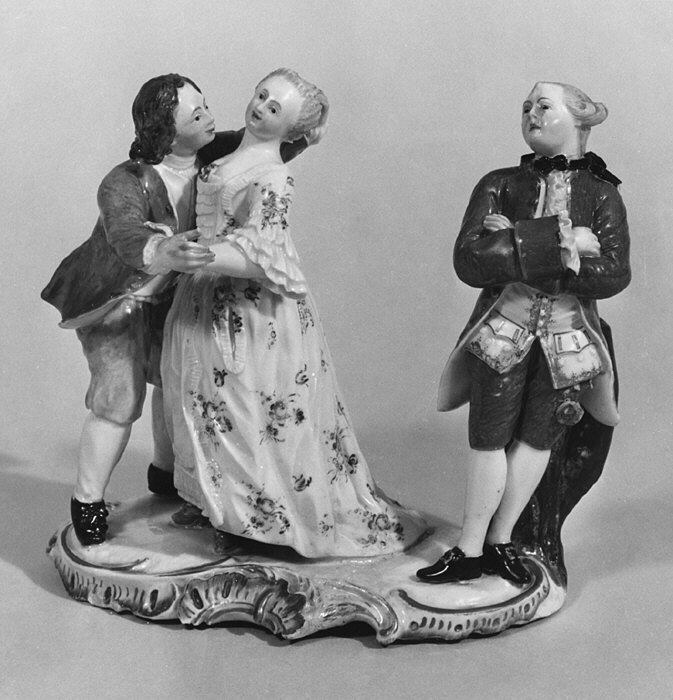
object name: group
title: Le Baiser Rendu (one of a pair)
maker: höchst manufactory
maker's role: manufactory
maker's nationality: german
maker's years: 1746-1796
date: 1755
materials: hard paste porcelain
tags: men,women,dancing